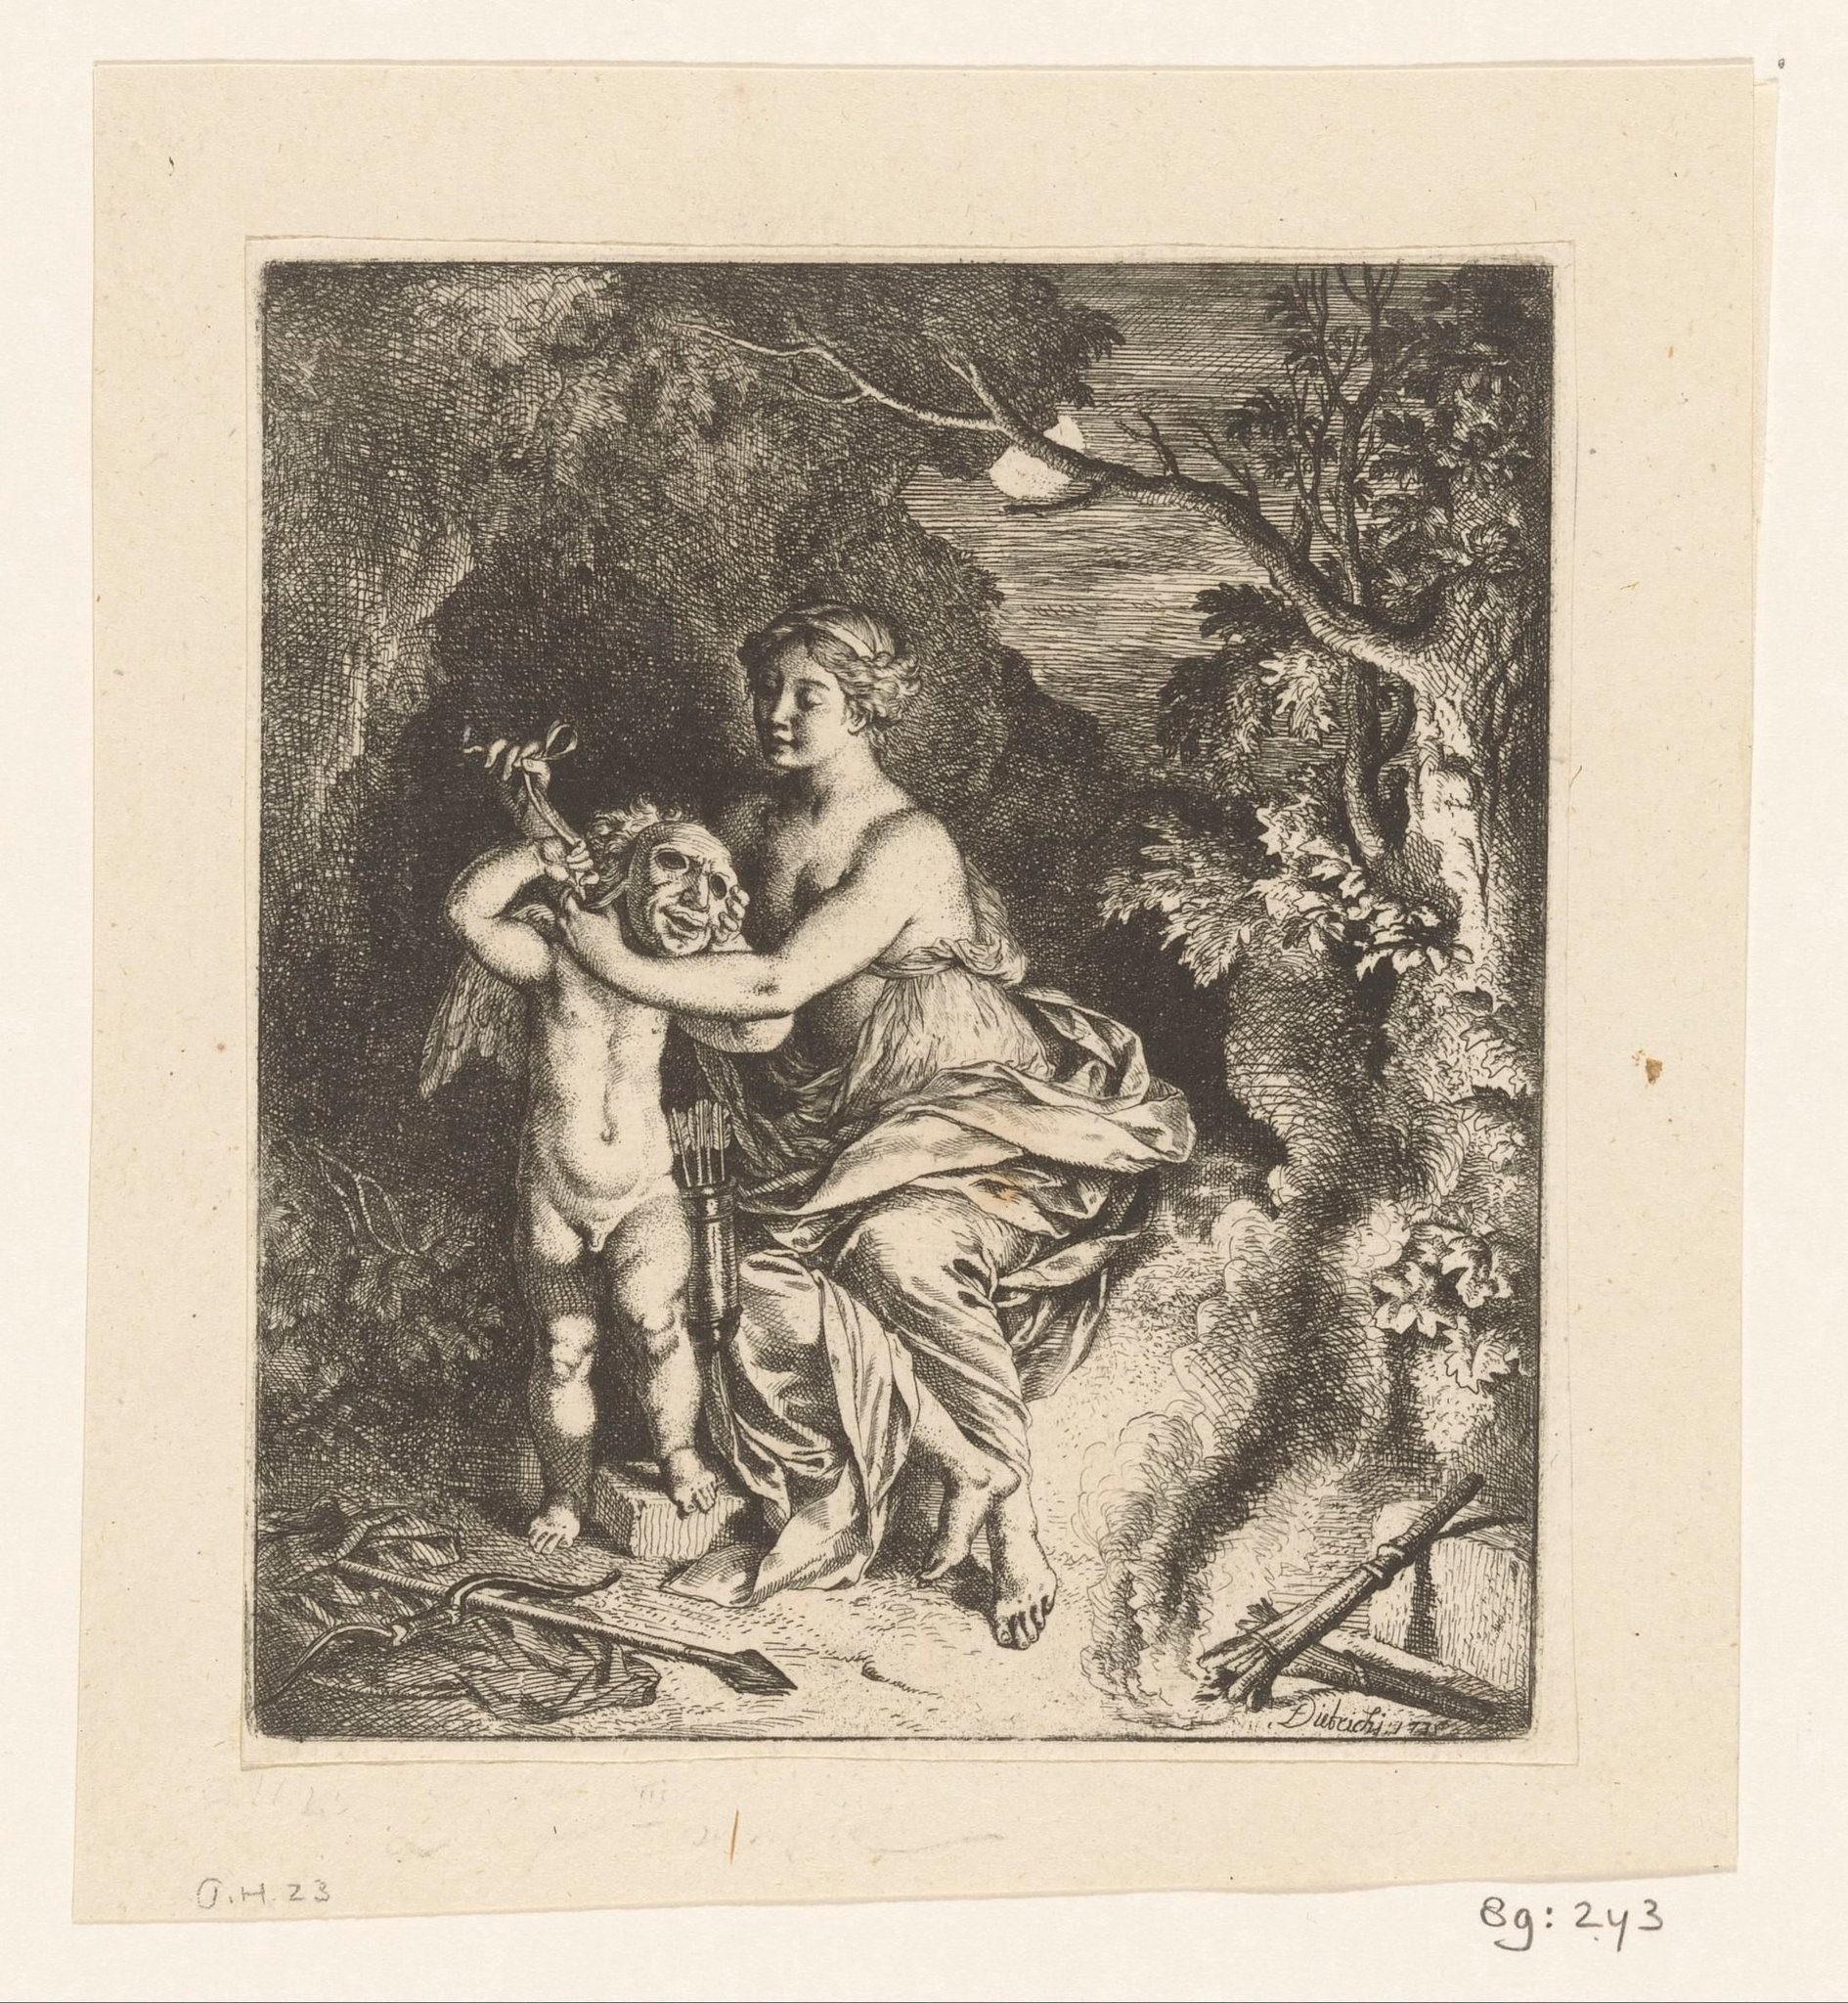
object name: print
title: Venus bindt Amor een masker voor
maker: christian wilhelm ernst dietrich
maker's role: artist, painter, print maker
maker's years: 1712-1774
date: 1735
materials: paper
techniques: etching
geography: netherlands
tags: mask, full moon, torch, archer's weapons: bow and arrow, venus taking care of cupid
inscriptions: collector's mark: Lugt 2760, collector's mark: Lugt 2228